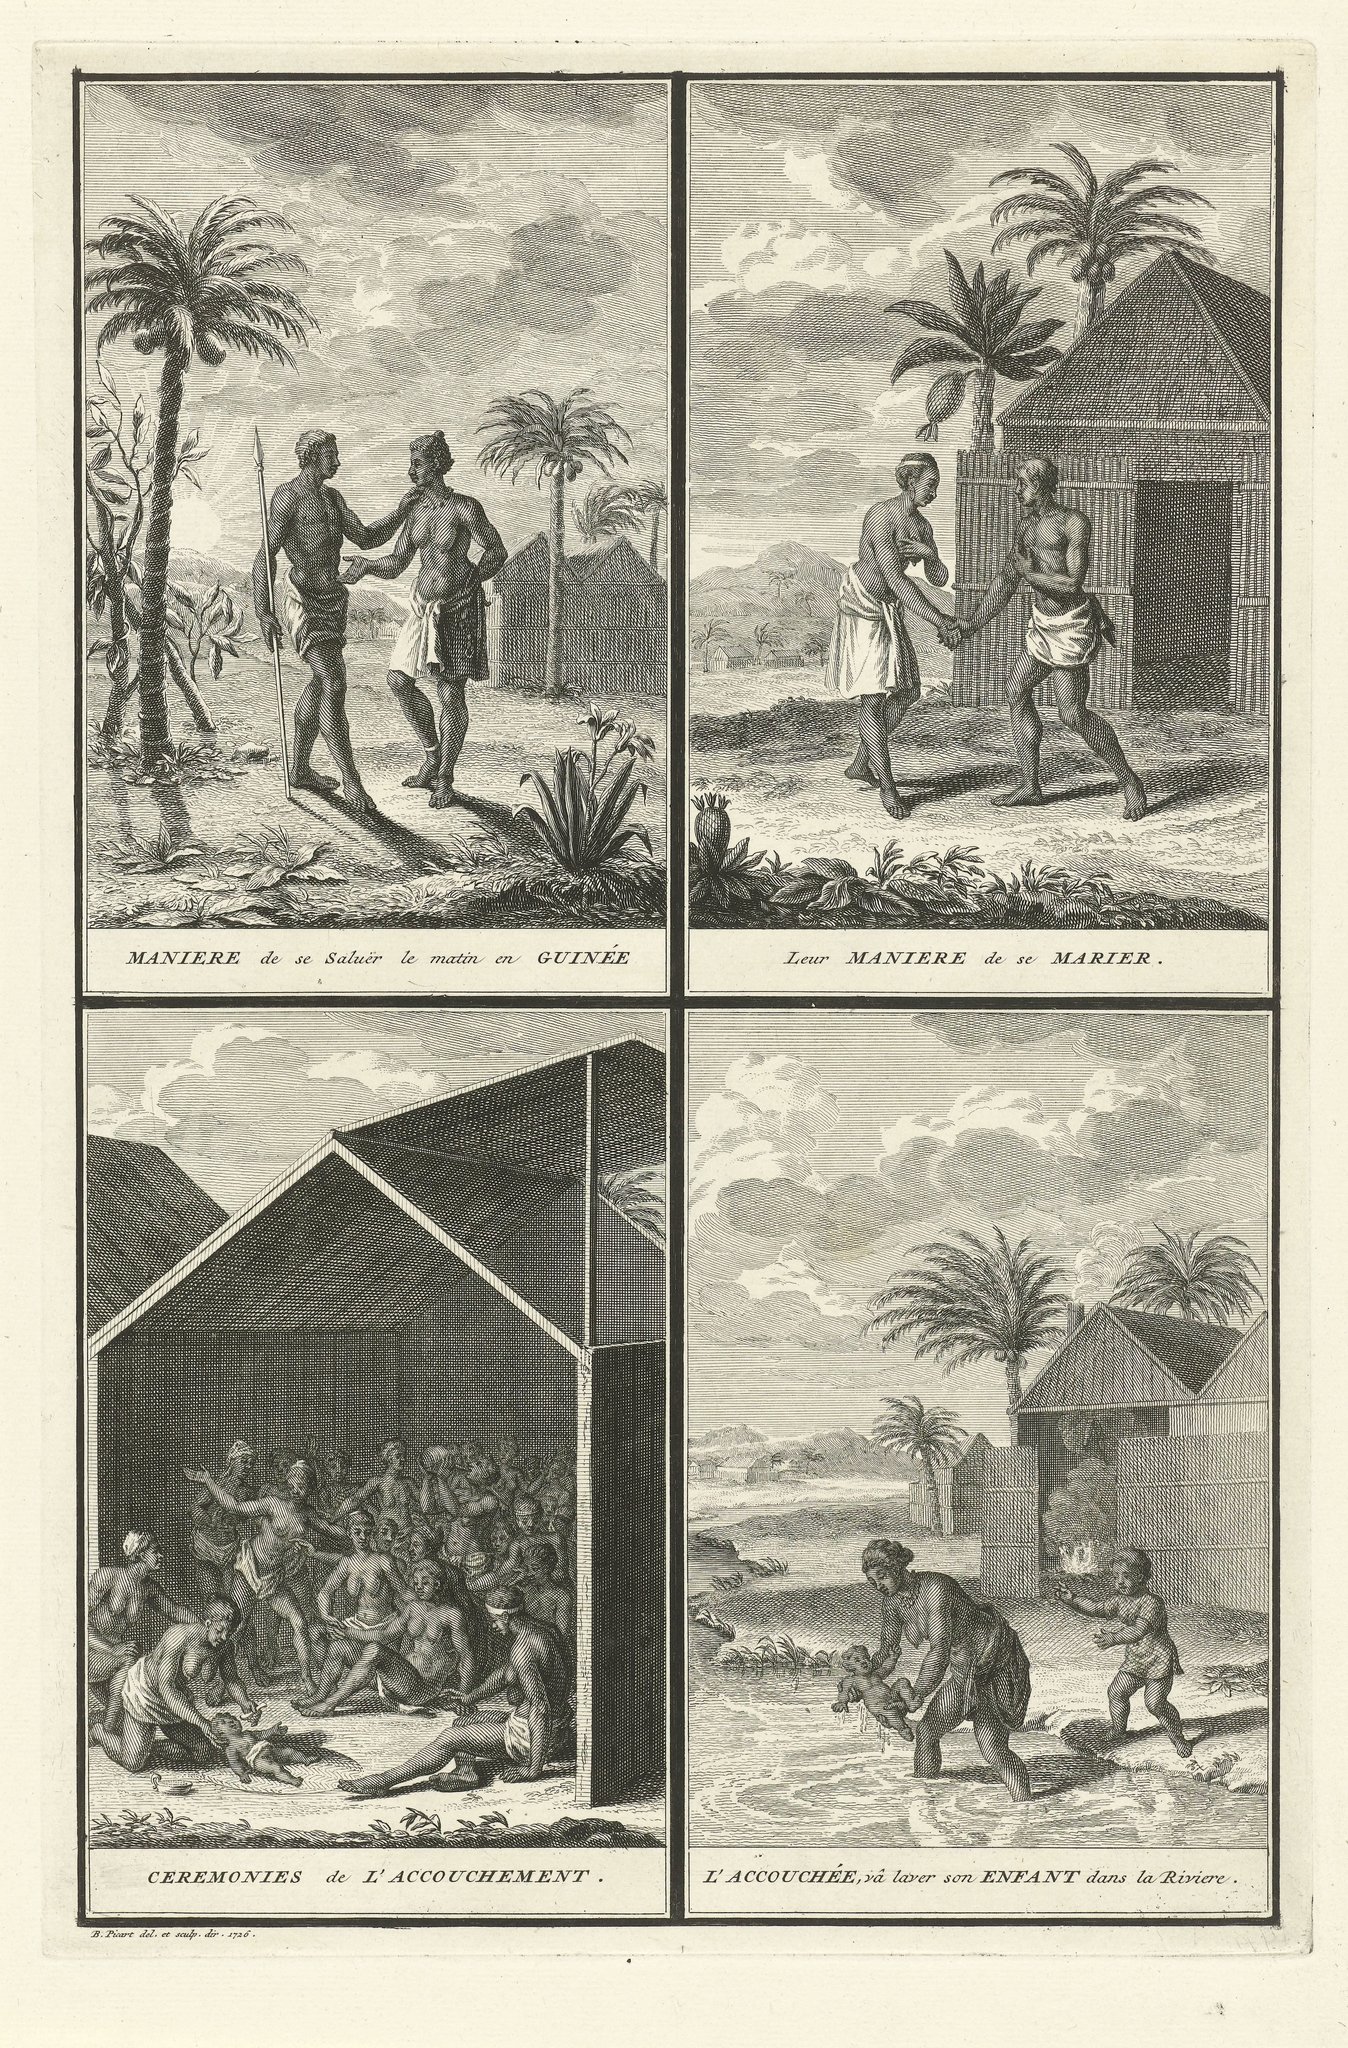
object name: print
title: Rituelen van inwoners uit Guinea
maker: bernard picart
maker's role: draughtsman, print maker, publisher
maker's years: 1673-1733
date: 1726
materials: paper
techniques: engraving, etching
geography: amsterdam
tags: ritual practices ~ stadia of human life (american indian religions), baptism, christening ceremony ~ the first of the seven sacraments, marriage, married couple, 'matrimonium', confinement, birth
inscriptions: collector's mark: Lugt 2228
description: Blad met vier voorstellingen van rituelen van inwoners uit Guinea. Boven: Een traditionele begroeting in de ochtend. Een huwelijksceremonie waarbij het bruidspaar elkaar de hand geeft. Onder: Geboorteceremonie direct nadat de moeder is bevallen. Een moeder wast haar pasgeboren kind in de rivier. Onder de voorstellingen een onderschrift in het Frans.